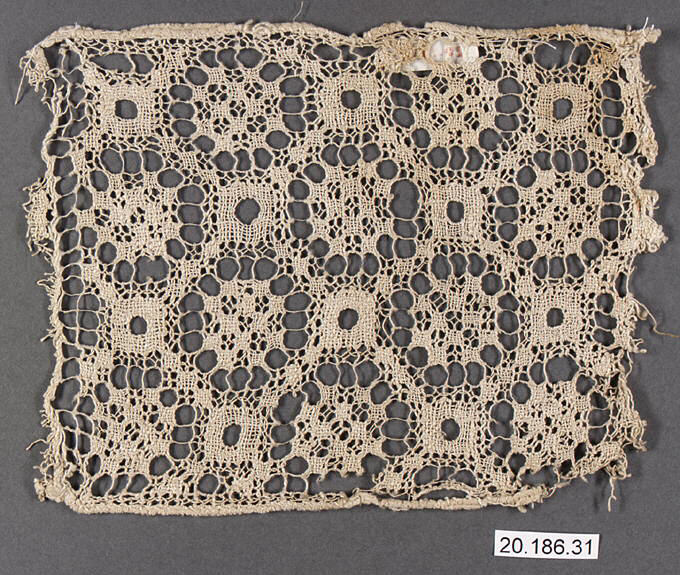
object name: fragment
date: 1501-1600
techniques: embroidery